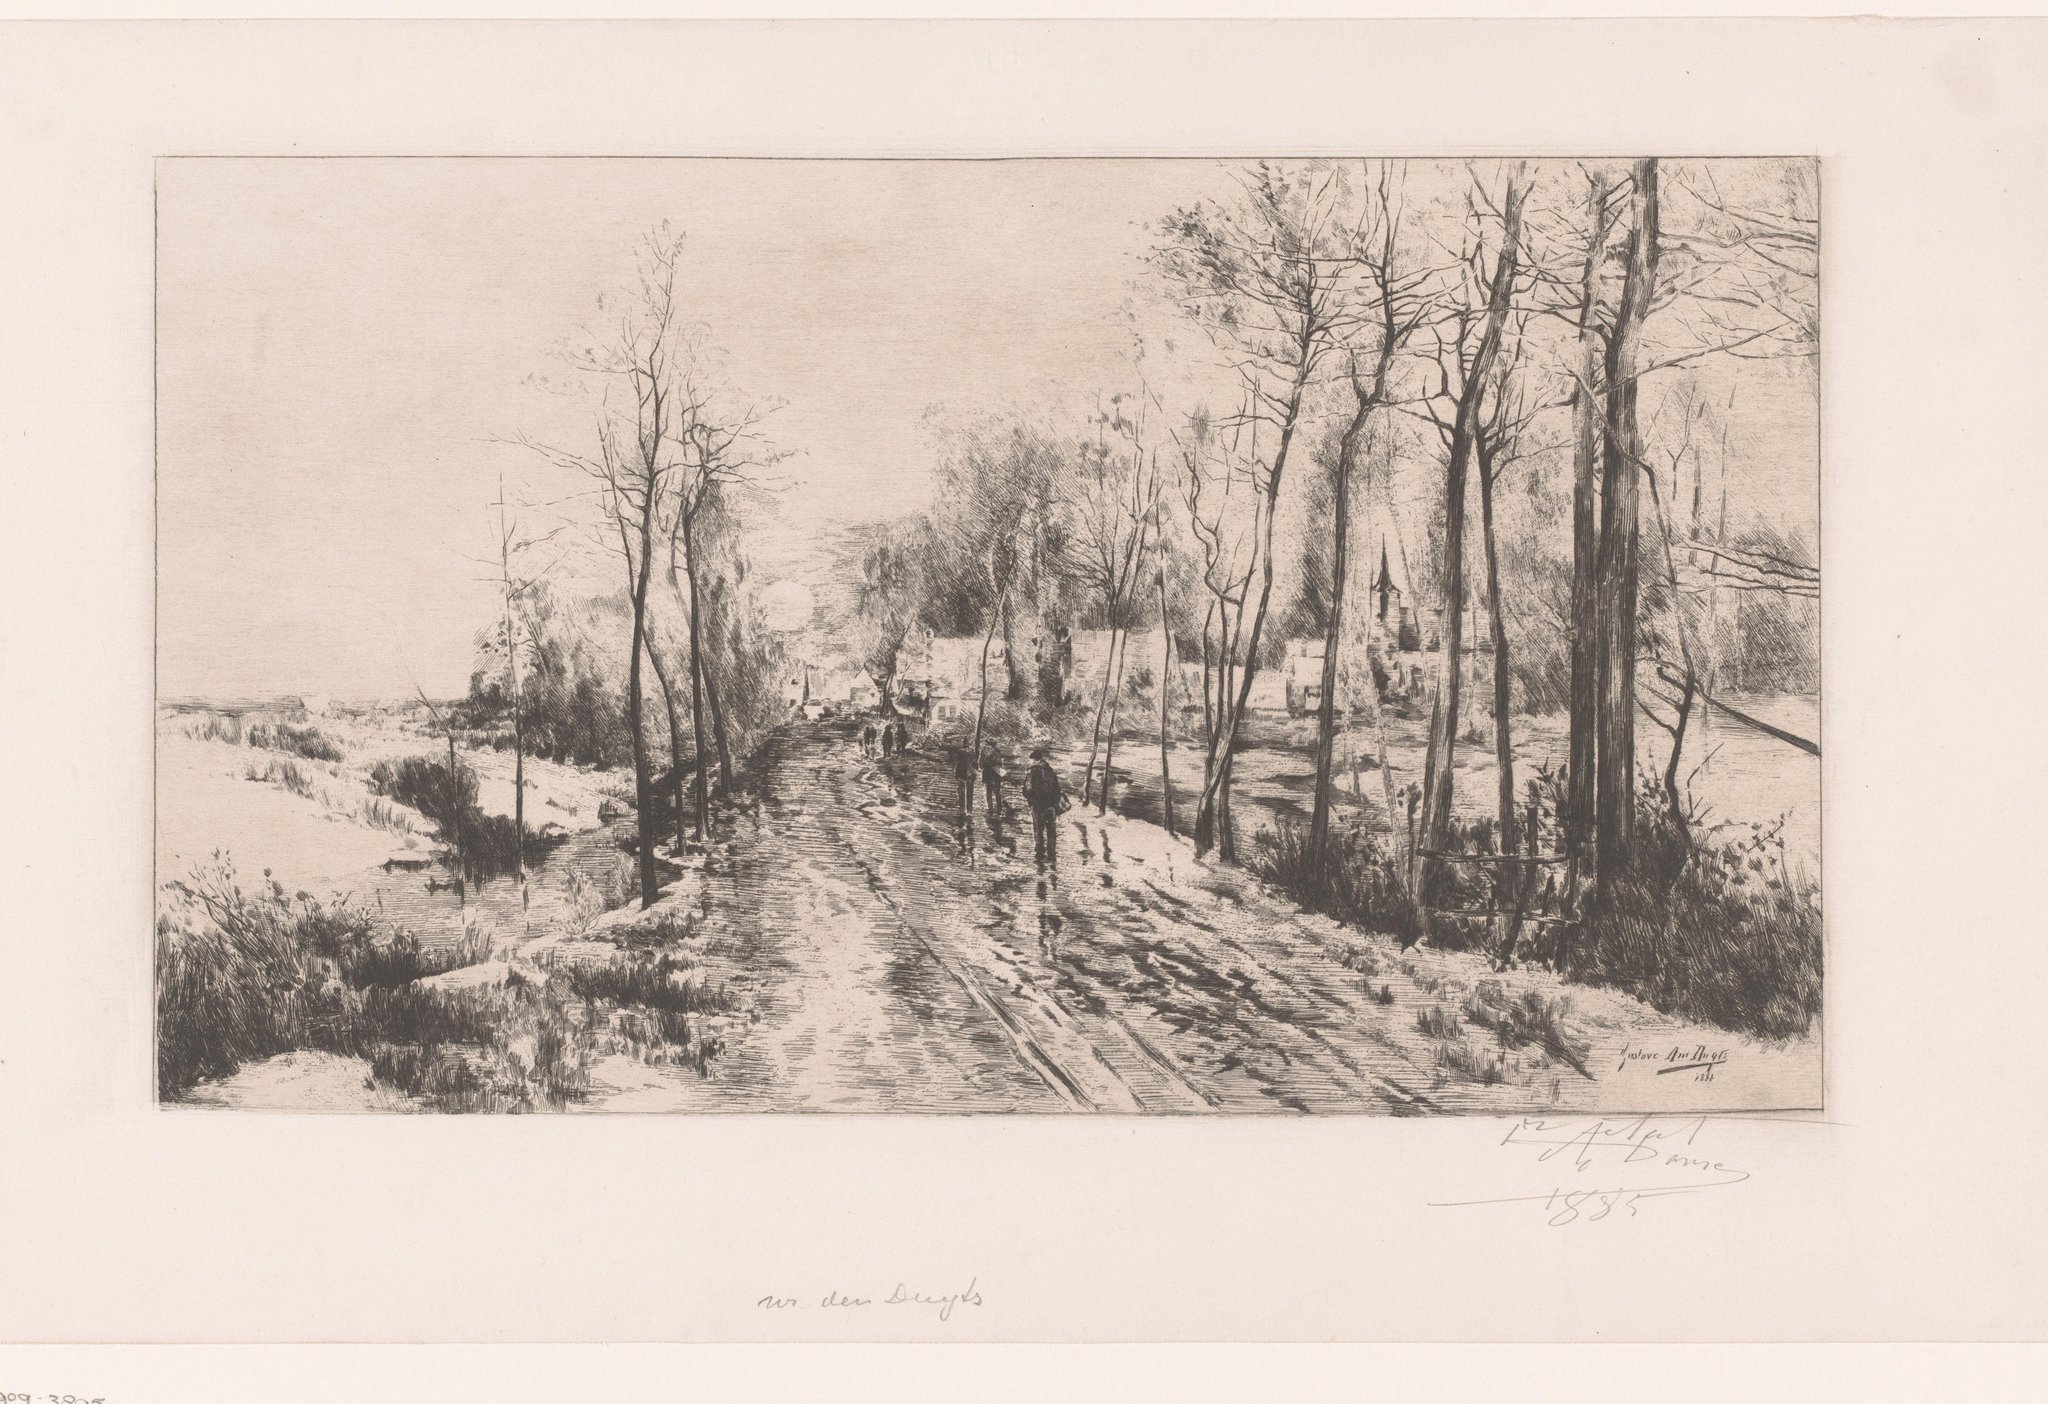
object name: print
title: Nachtelijk sneeuwlandschap met schimmige figuren op het pad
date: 1885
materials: paper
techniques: drypoint, etching, intaglio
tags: full moon, night ~ landscape (sometimes titled 'nox')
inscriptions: annotation: ‘1er état’, collector's mark: Lugt 2228